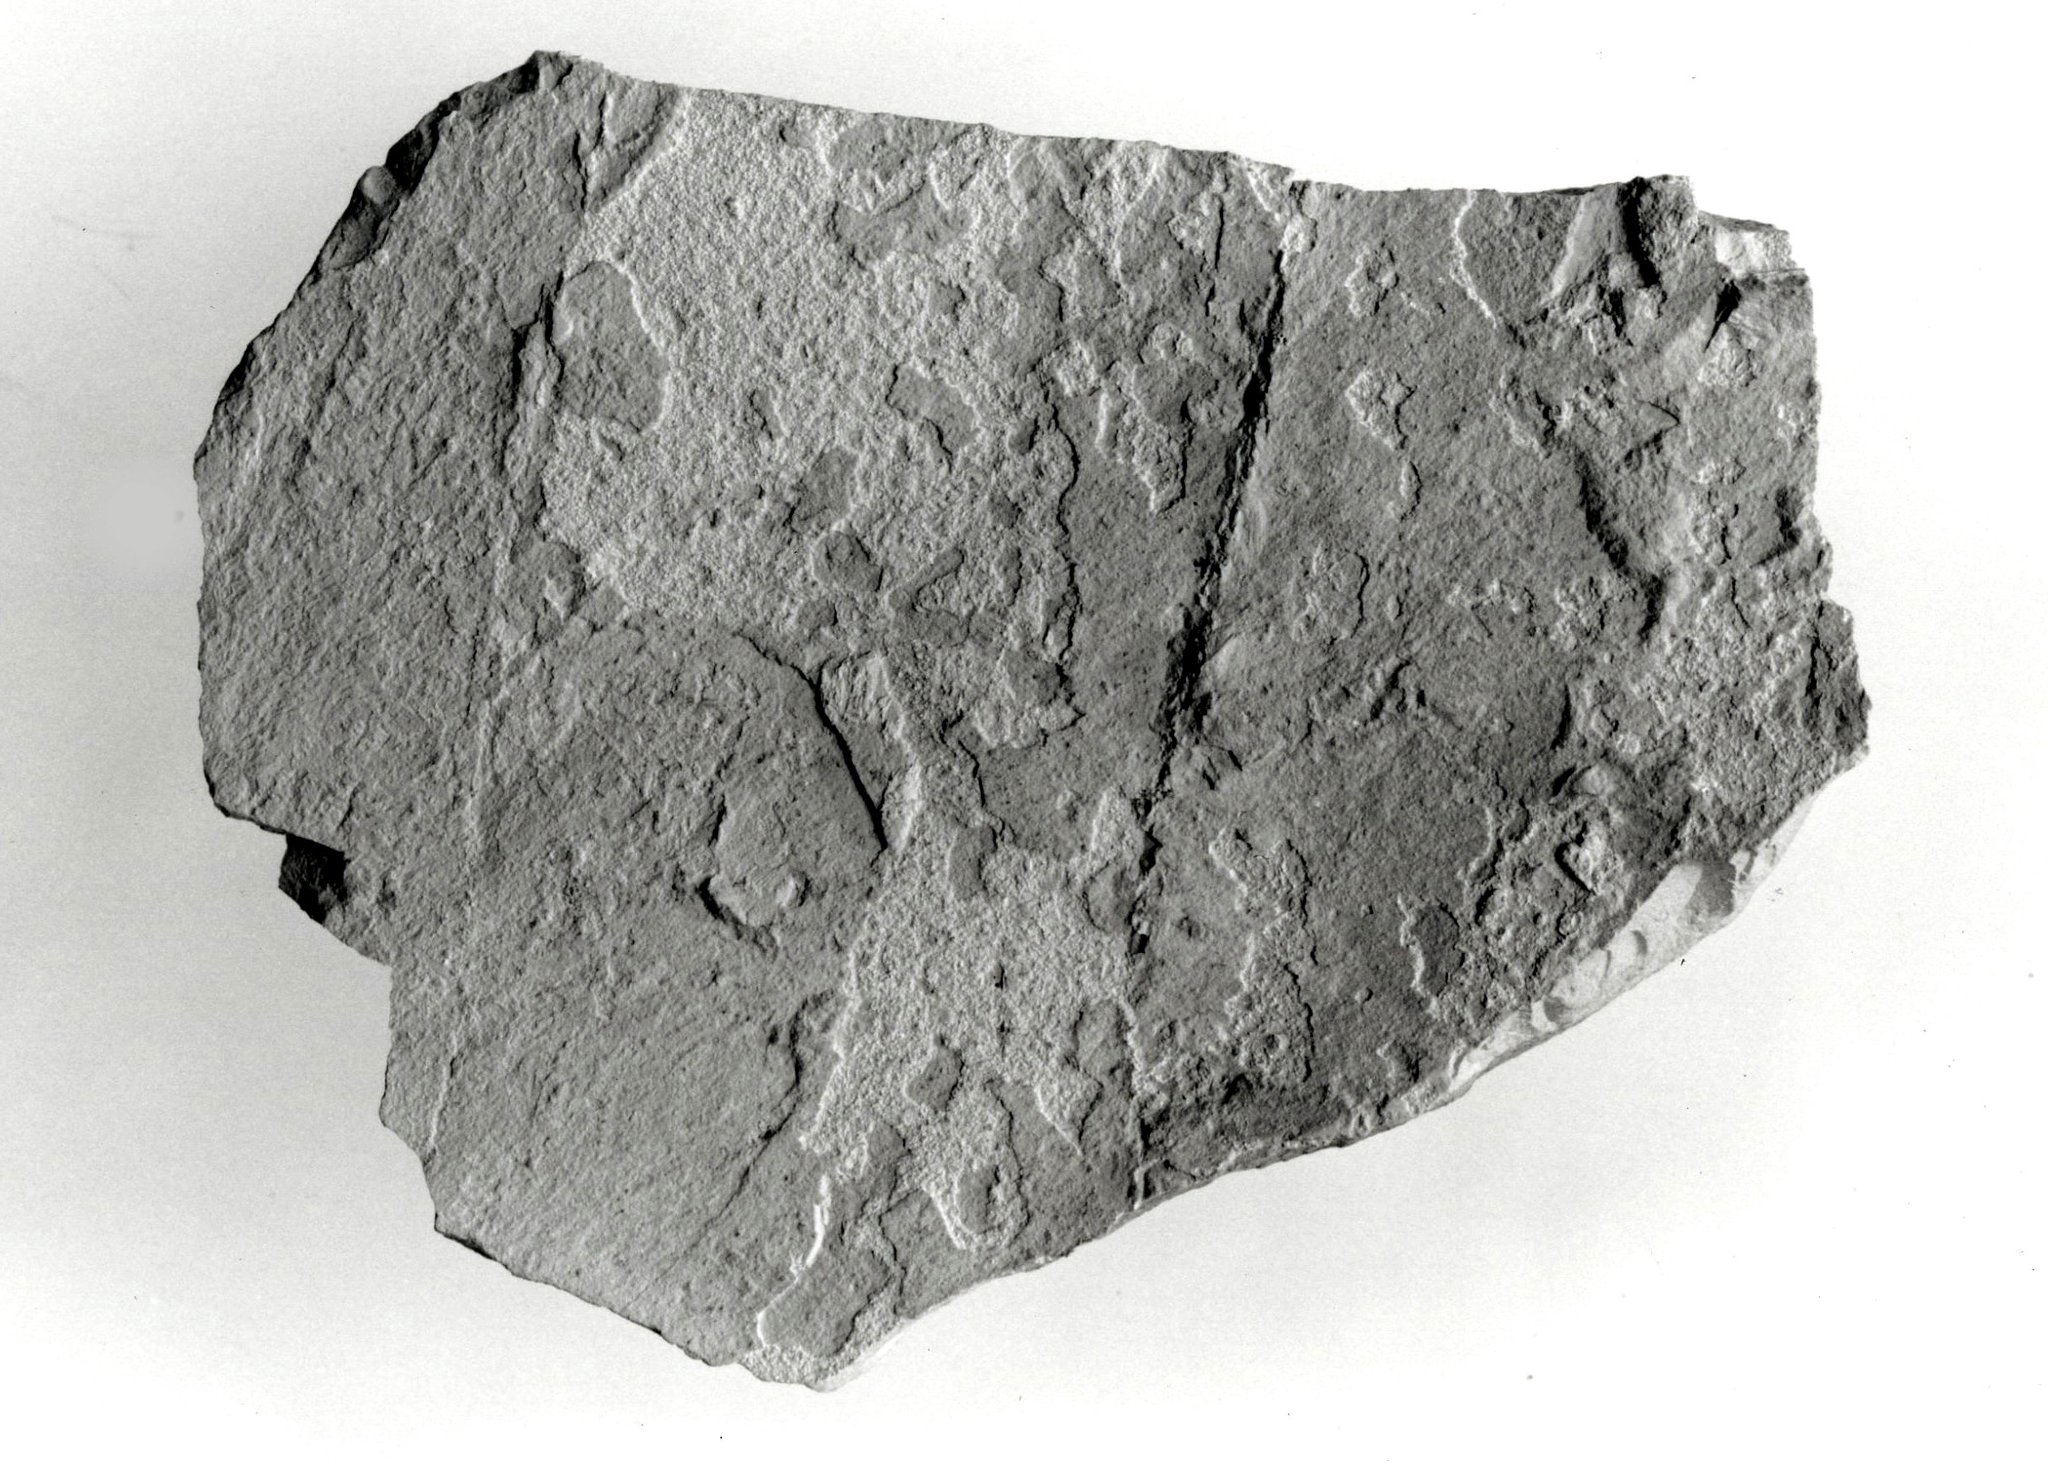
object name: relief, tomb of nespekashuty, wall casing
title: Wall casing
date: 664-610 BCE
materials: limestone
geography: egypt